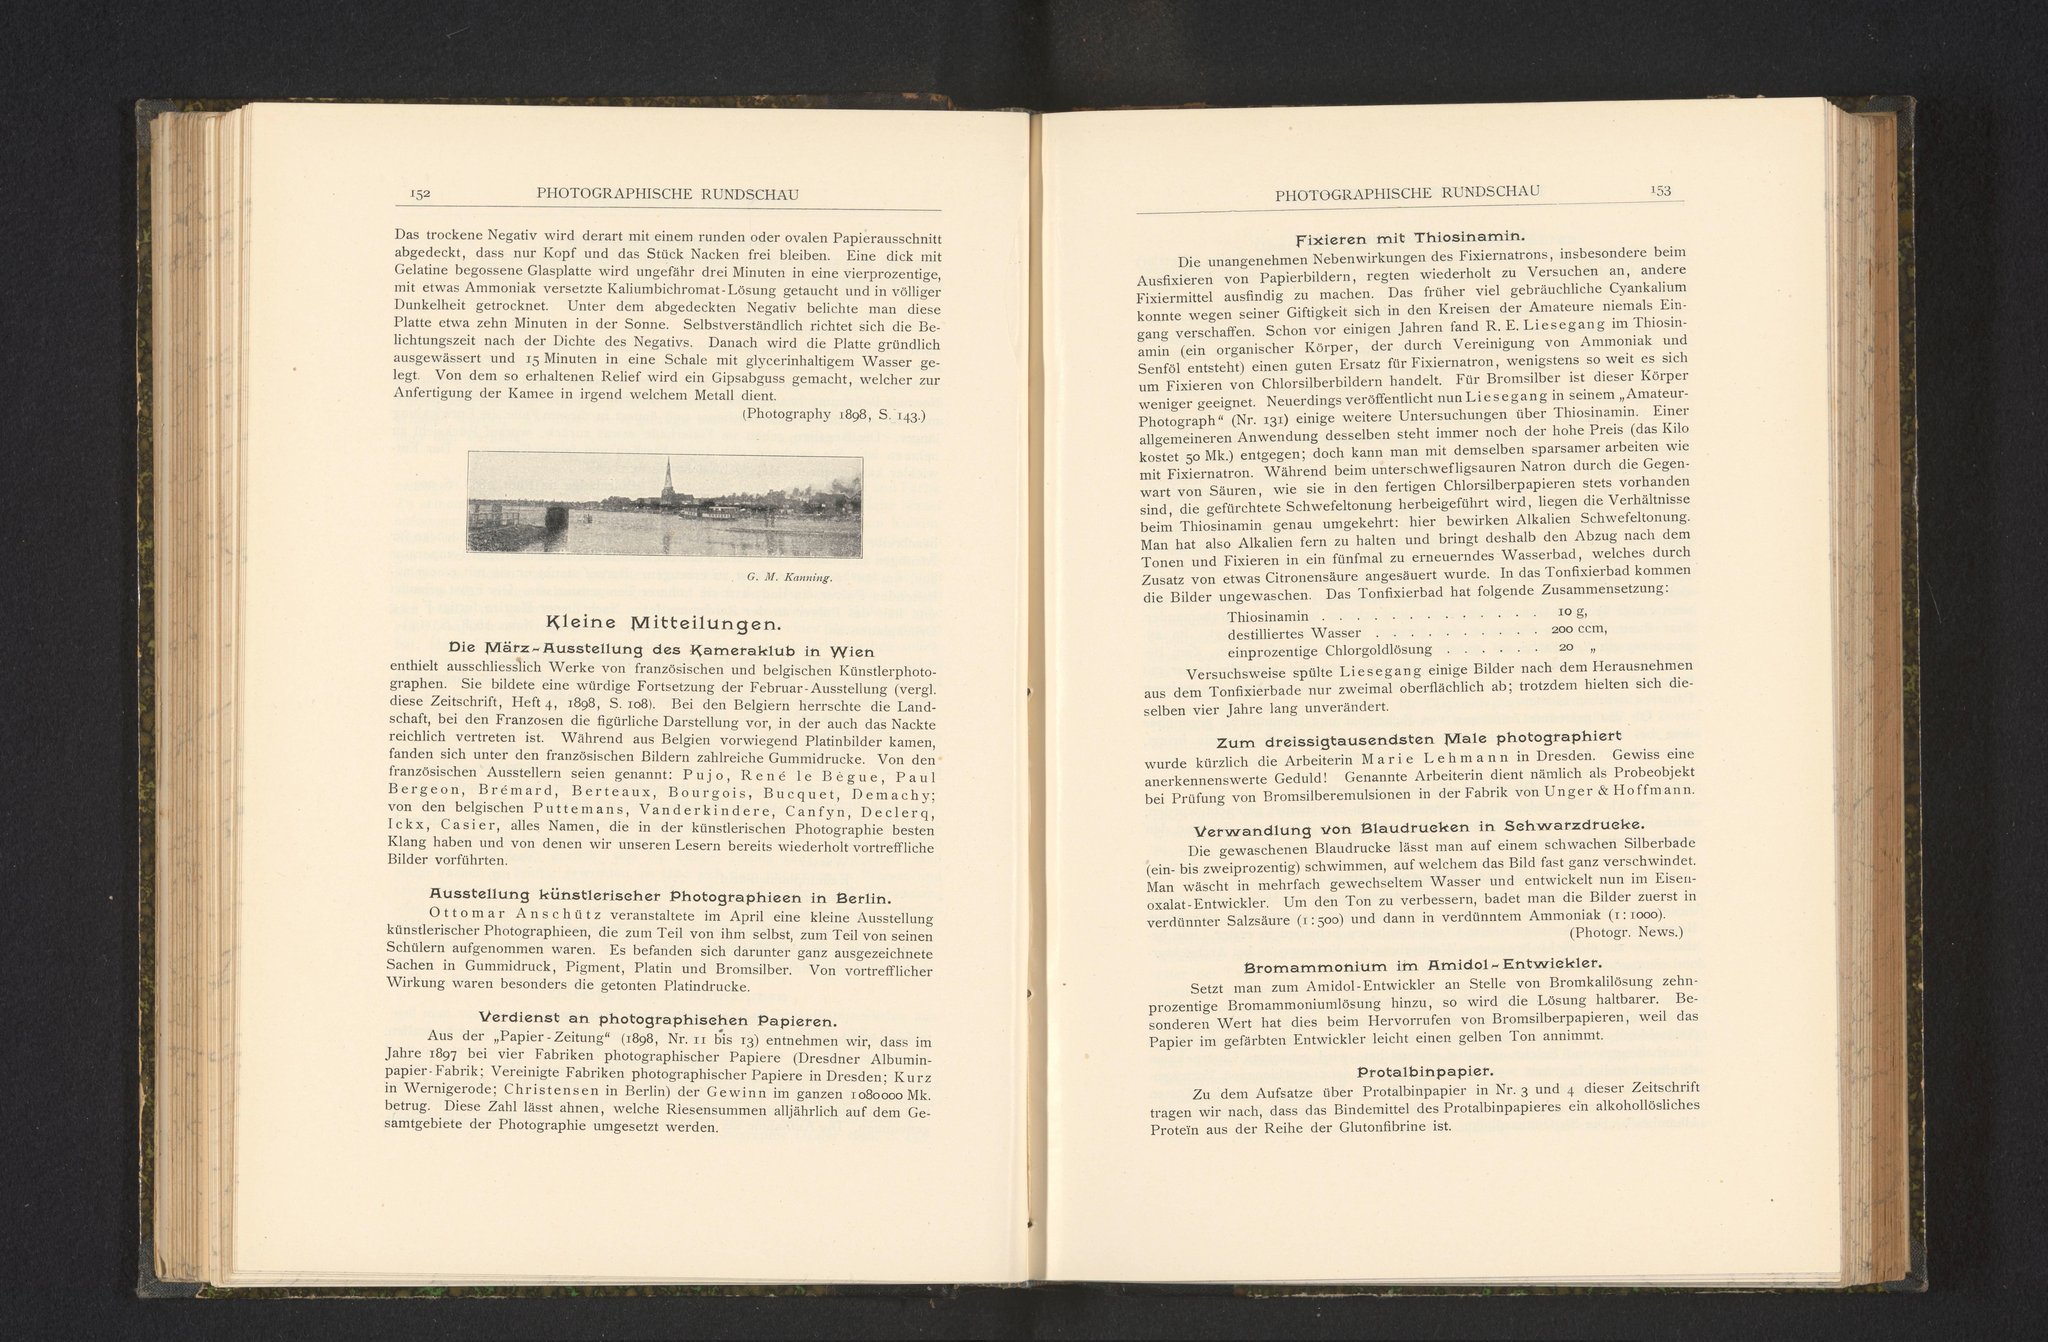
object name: page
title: Gezicht op een rivier in een stad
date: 1893-1898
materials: paper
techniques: autotype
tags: city-view in general; 'veduta', river